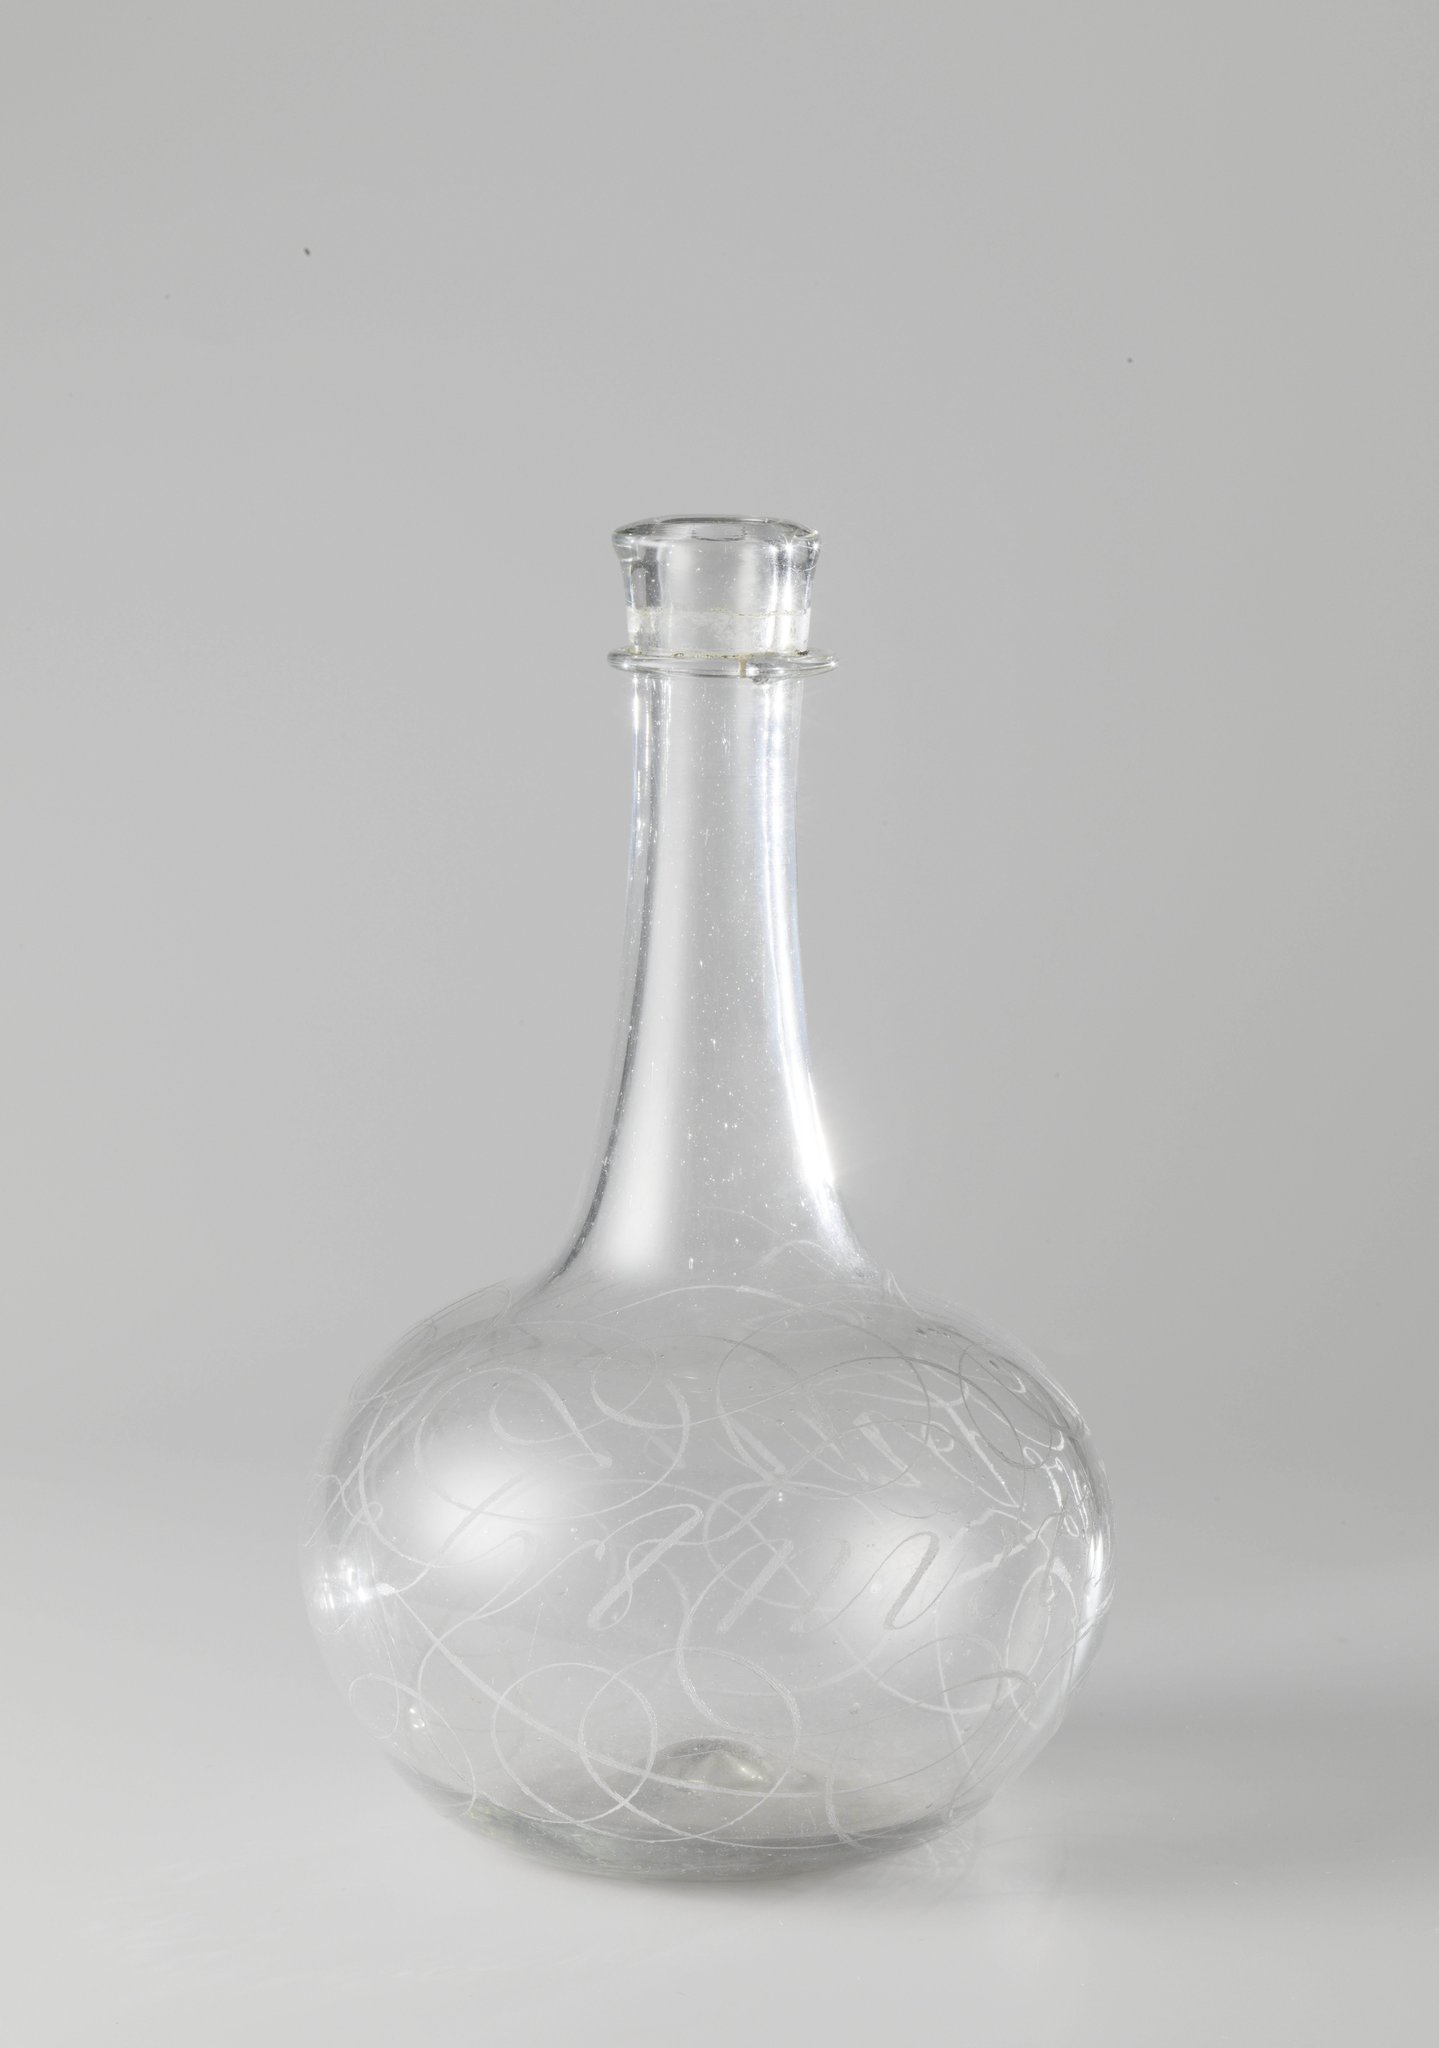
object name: bottle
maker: willem jacobszoon van heemskerk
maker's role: dichter, glasgraveur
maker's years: 1613-1692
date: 1685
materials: glass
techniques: diamond point engraving, glassblowing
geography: leiden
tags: leiden, willem jacobszoon van heemskerk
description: The inscription comes from the biblical verse: ‘Show not forth wisdom out of time’.